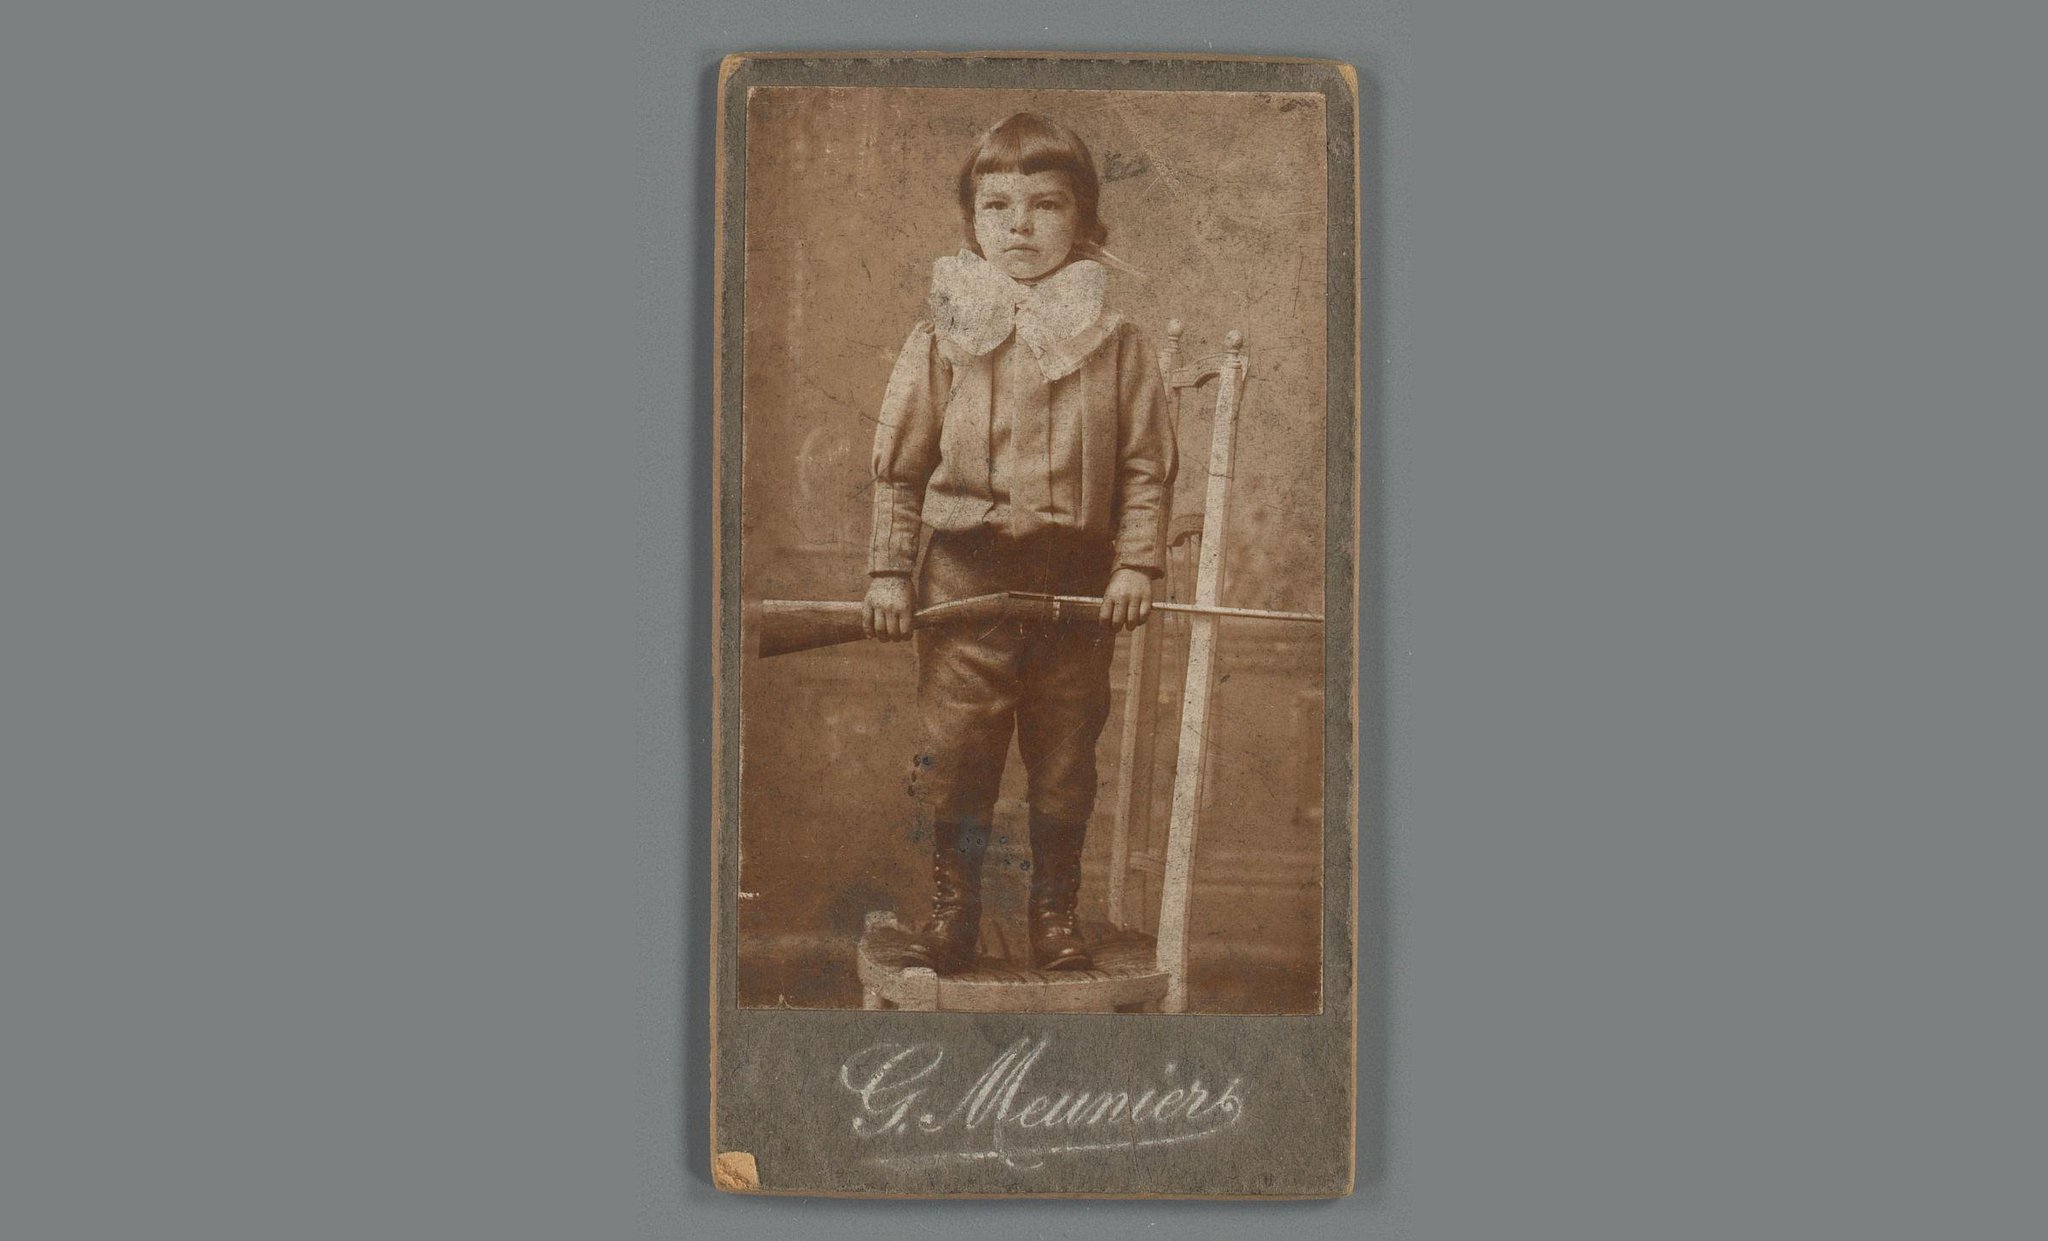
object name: photograph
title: Miniatuurportret van een onbekende jongen staande op een stoel met een speelgoedgeweer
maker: georges meunier (fotograaf)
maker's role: fotograaf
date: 1880-1910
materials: paper, cardboard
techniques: gelatin silver print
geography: france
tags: boy (child between toddler and youth), anonymous historical person portrayed, (playing with) toys, france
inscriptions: number: ‘4729’, inscription: ‘G. Meunier’